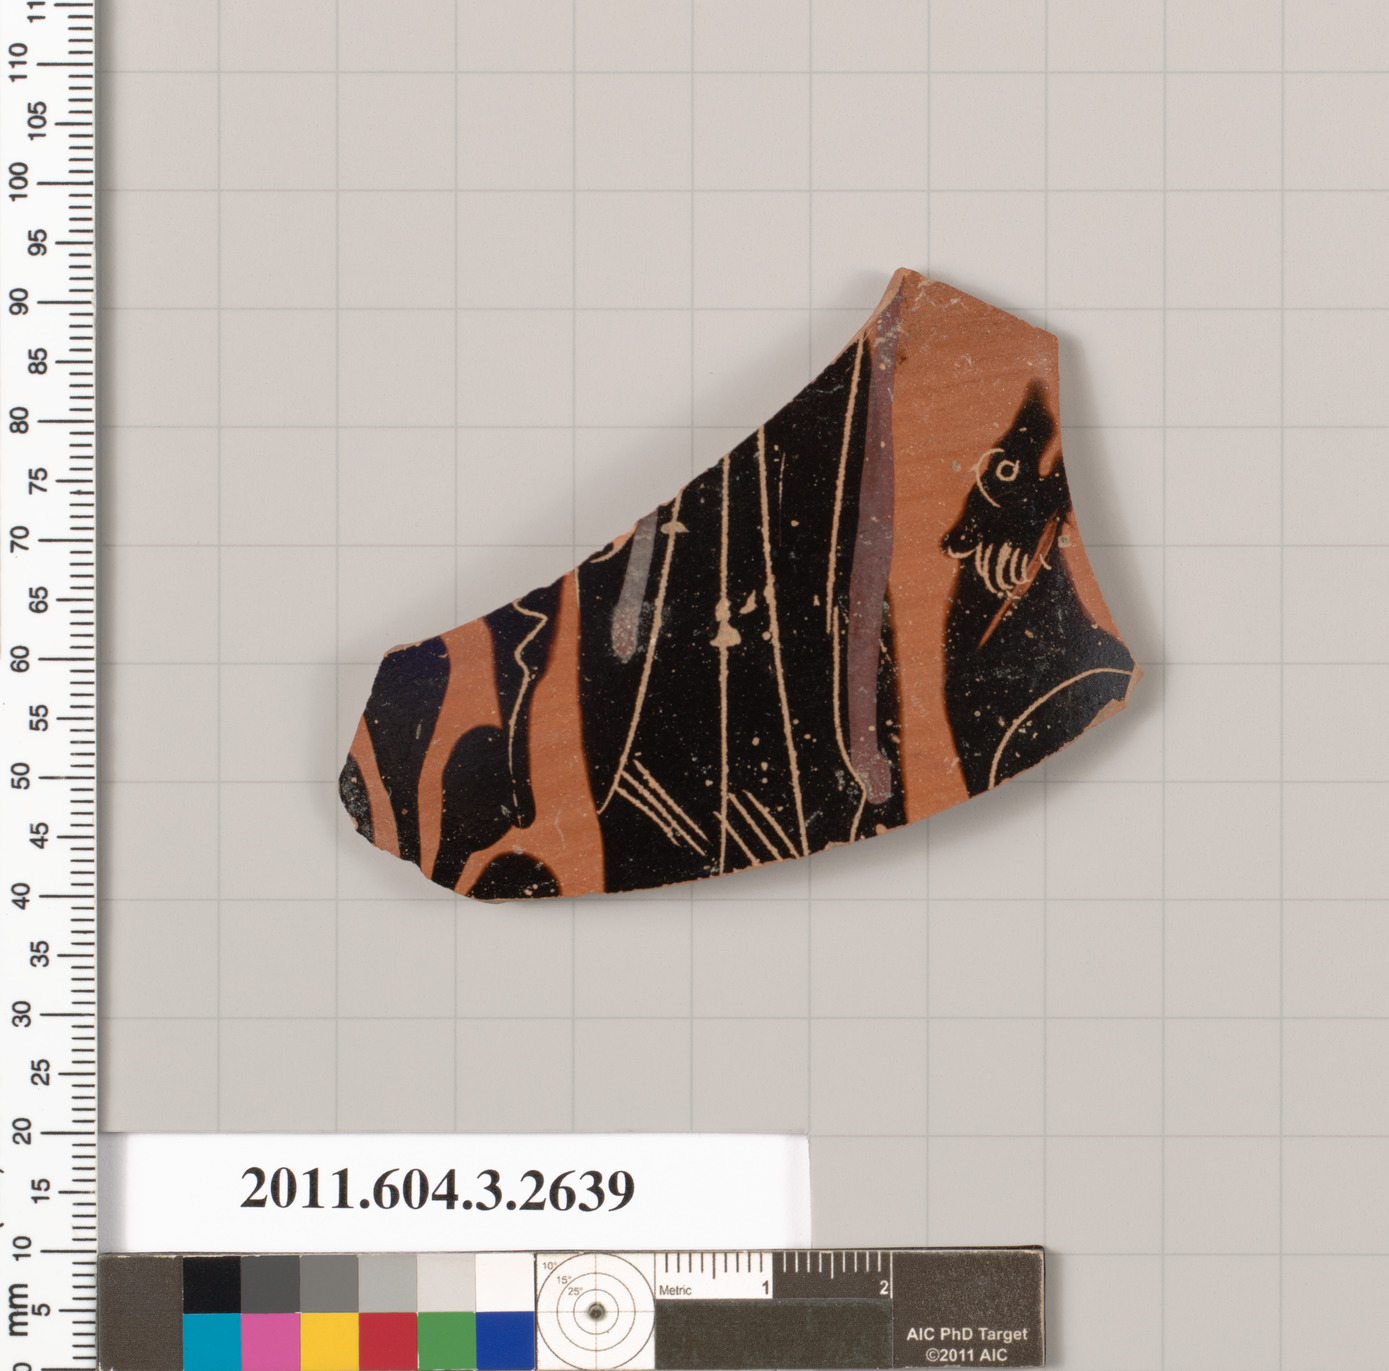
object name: neck amphora fragment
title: Terracotta fragment of a neck-amphora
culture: greek, attic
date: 550-526 BCE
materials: terracotta